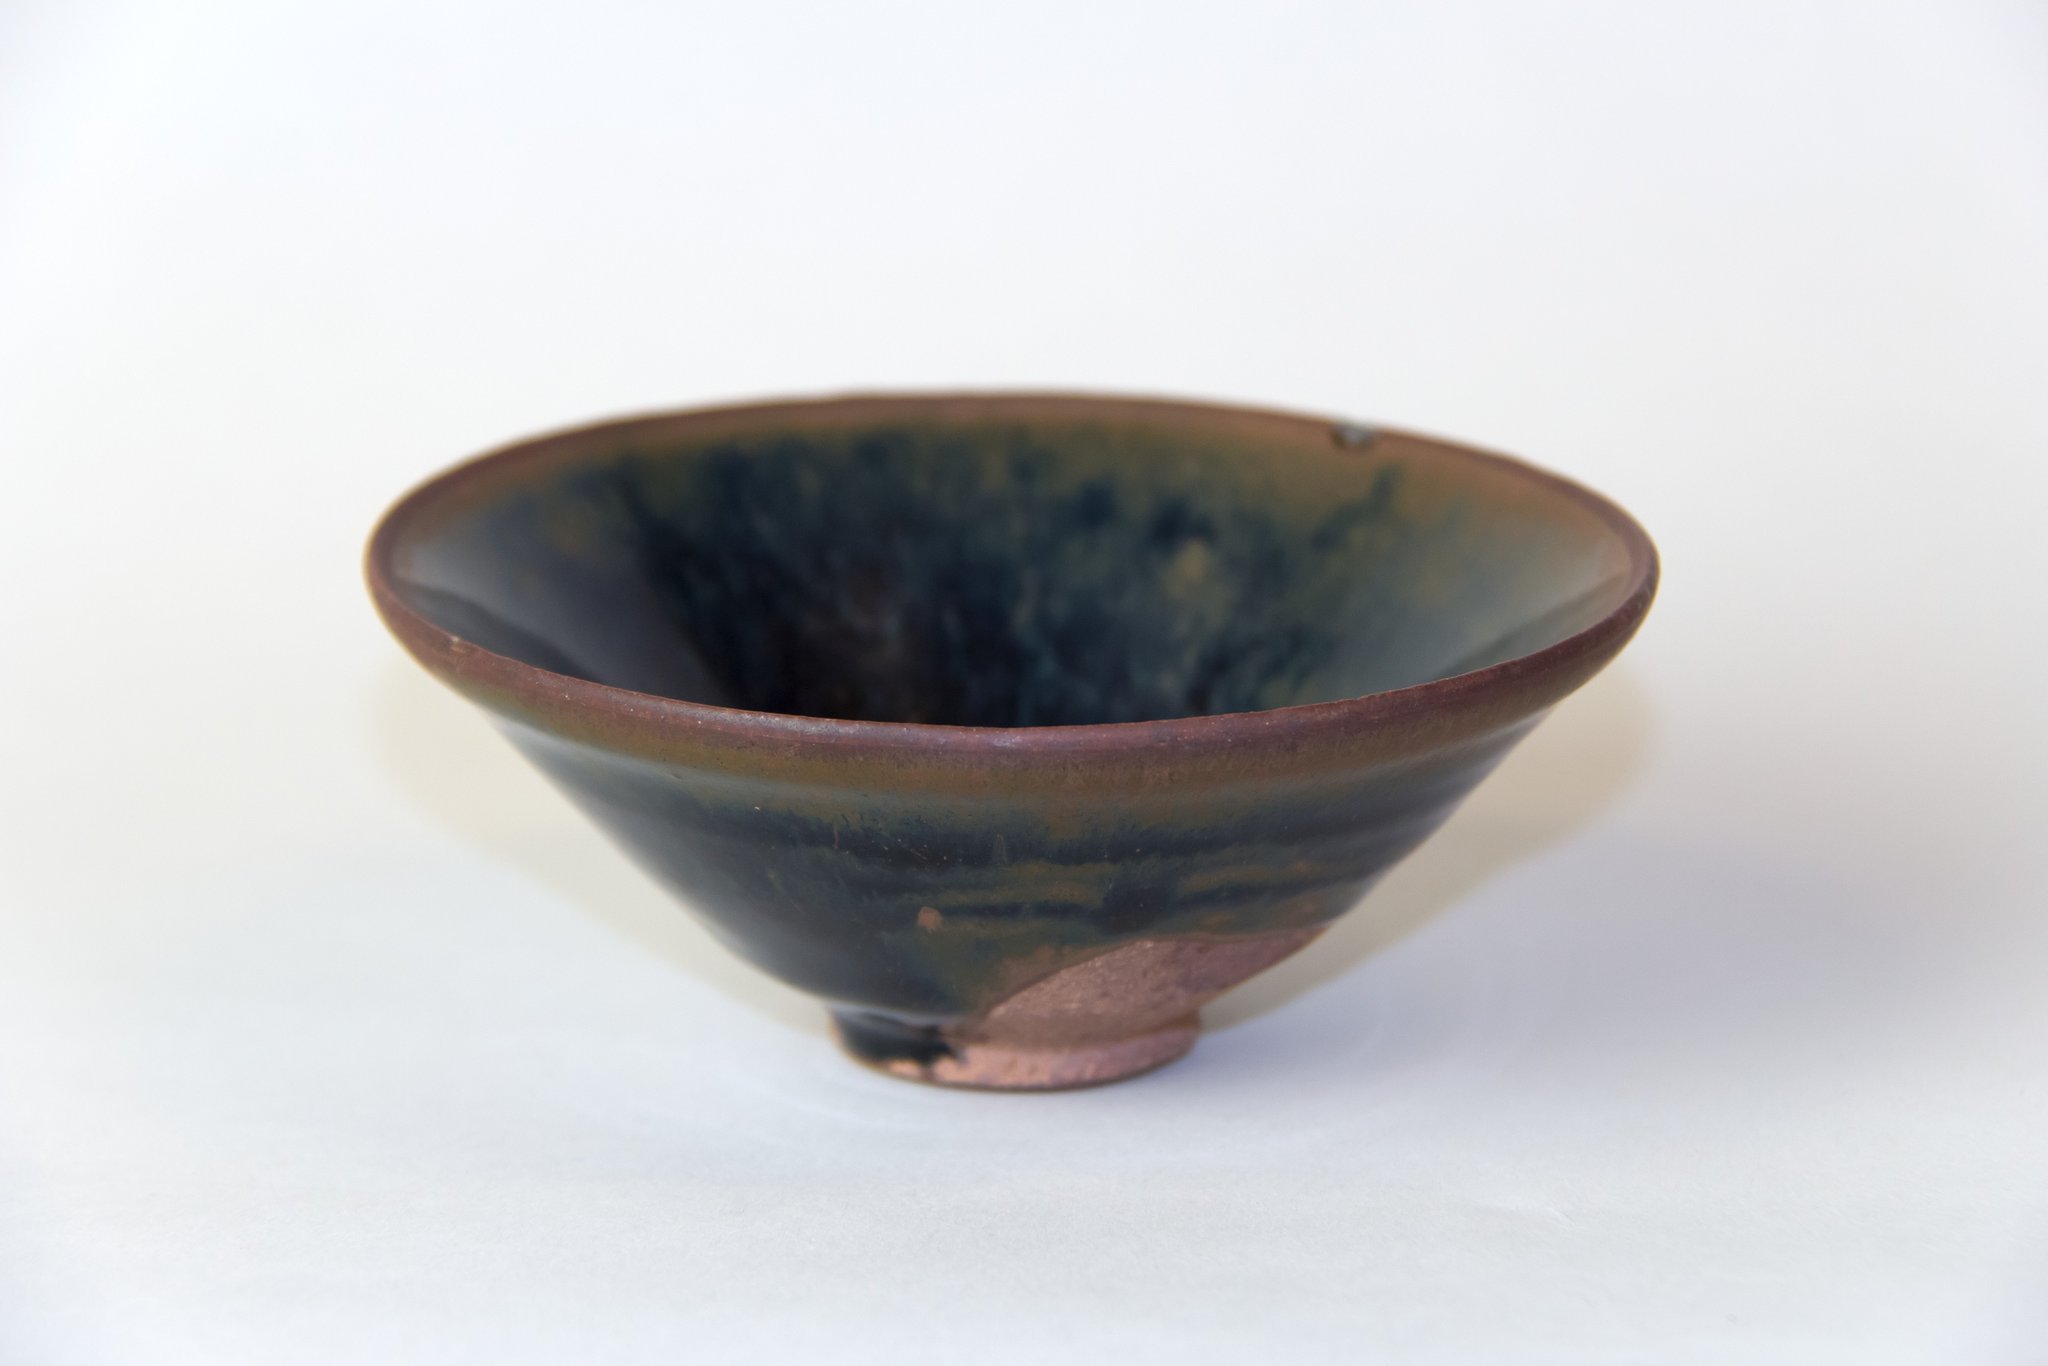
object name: teabowl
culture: chinese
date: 1127-1279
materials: glaze, stoneware